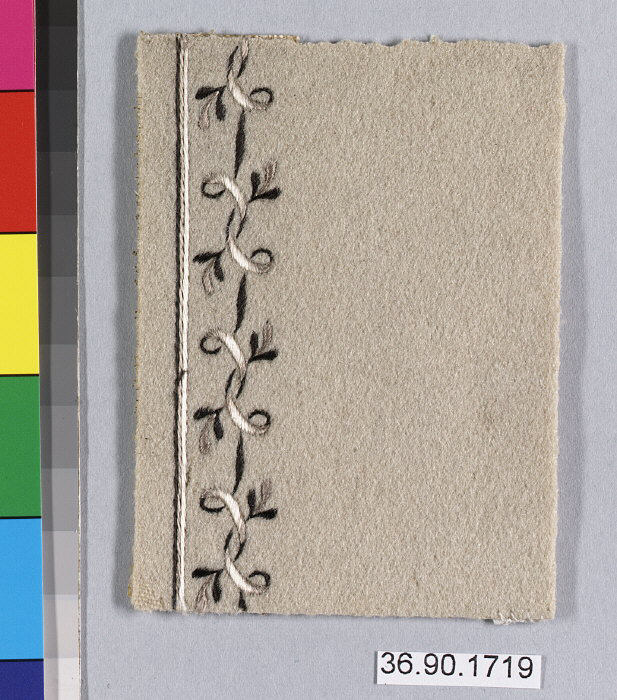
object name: sample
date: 1801-1833